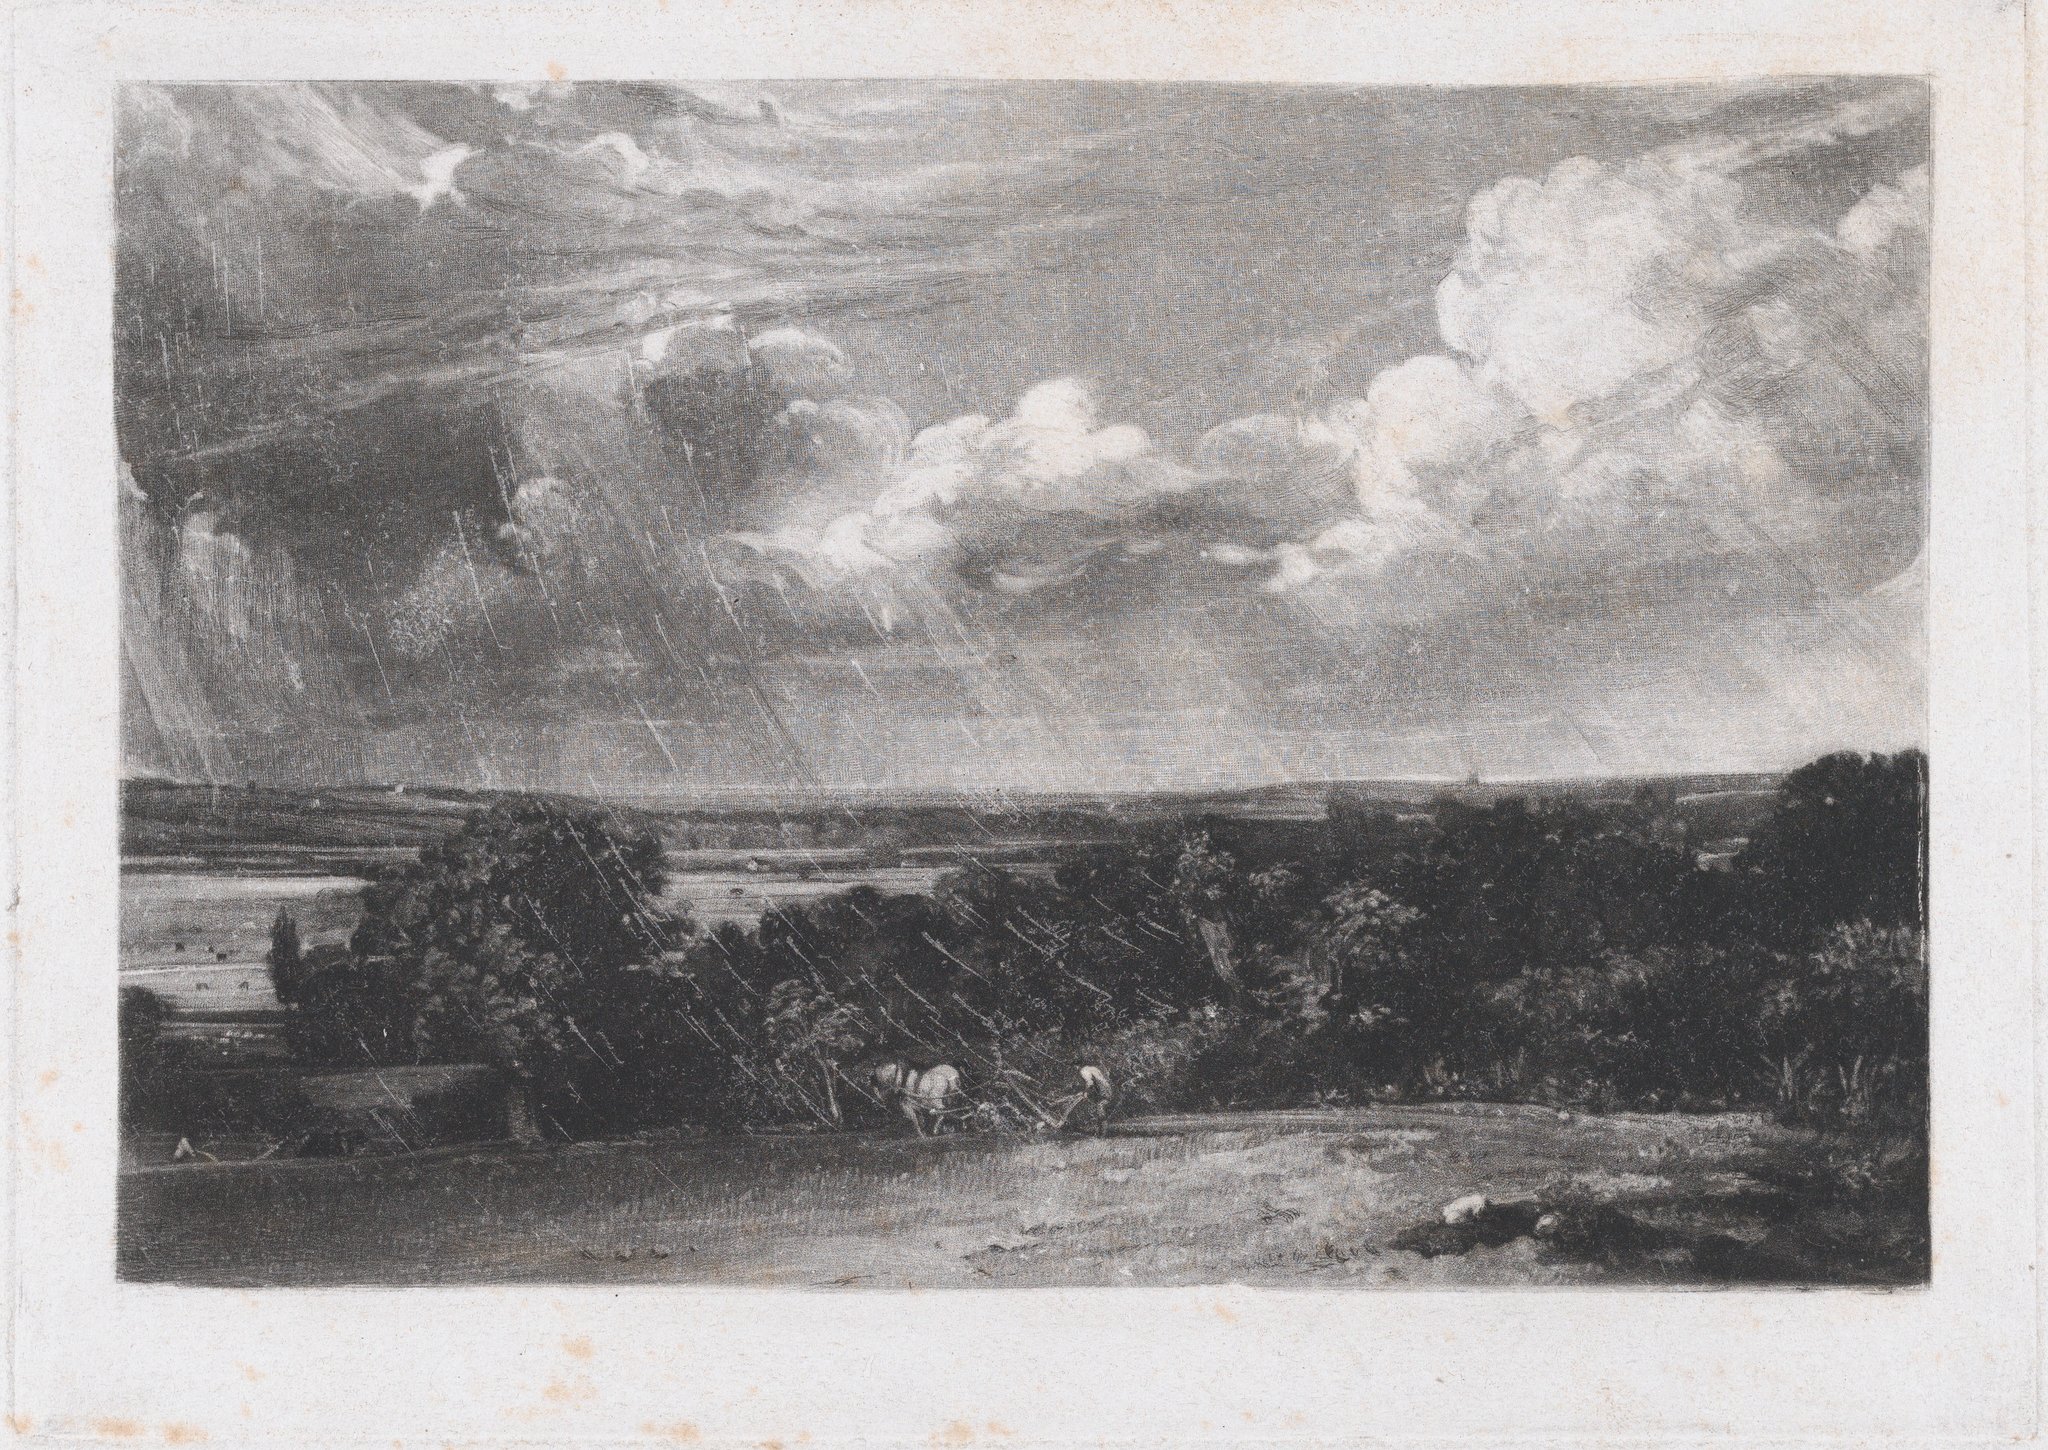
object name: print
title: A Summerland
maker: david lucas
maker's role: artist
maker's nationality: british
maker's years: 1802-1881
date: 1829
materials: chalk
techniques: drypoint, mezzotint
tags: animals,men,landscapes,rain